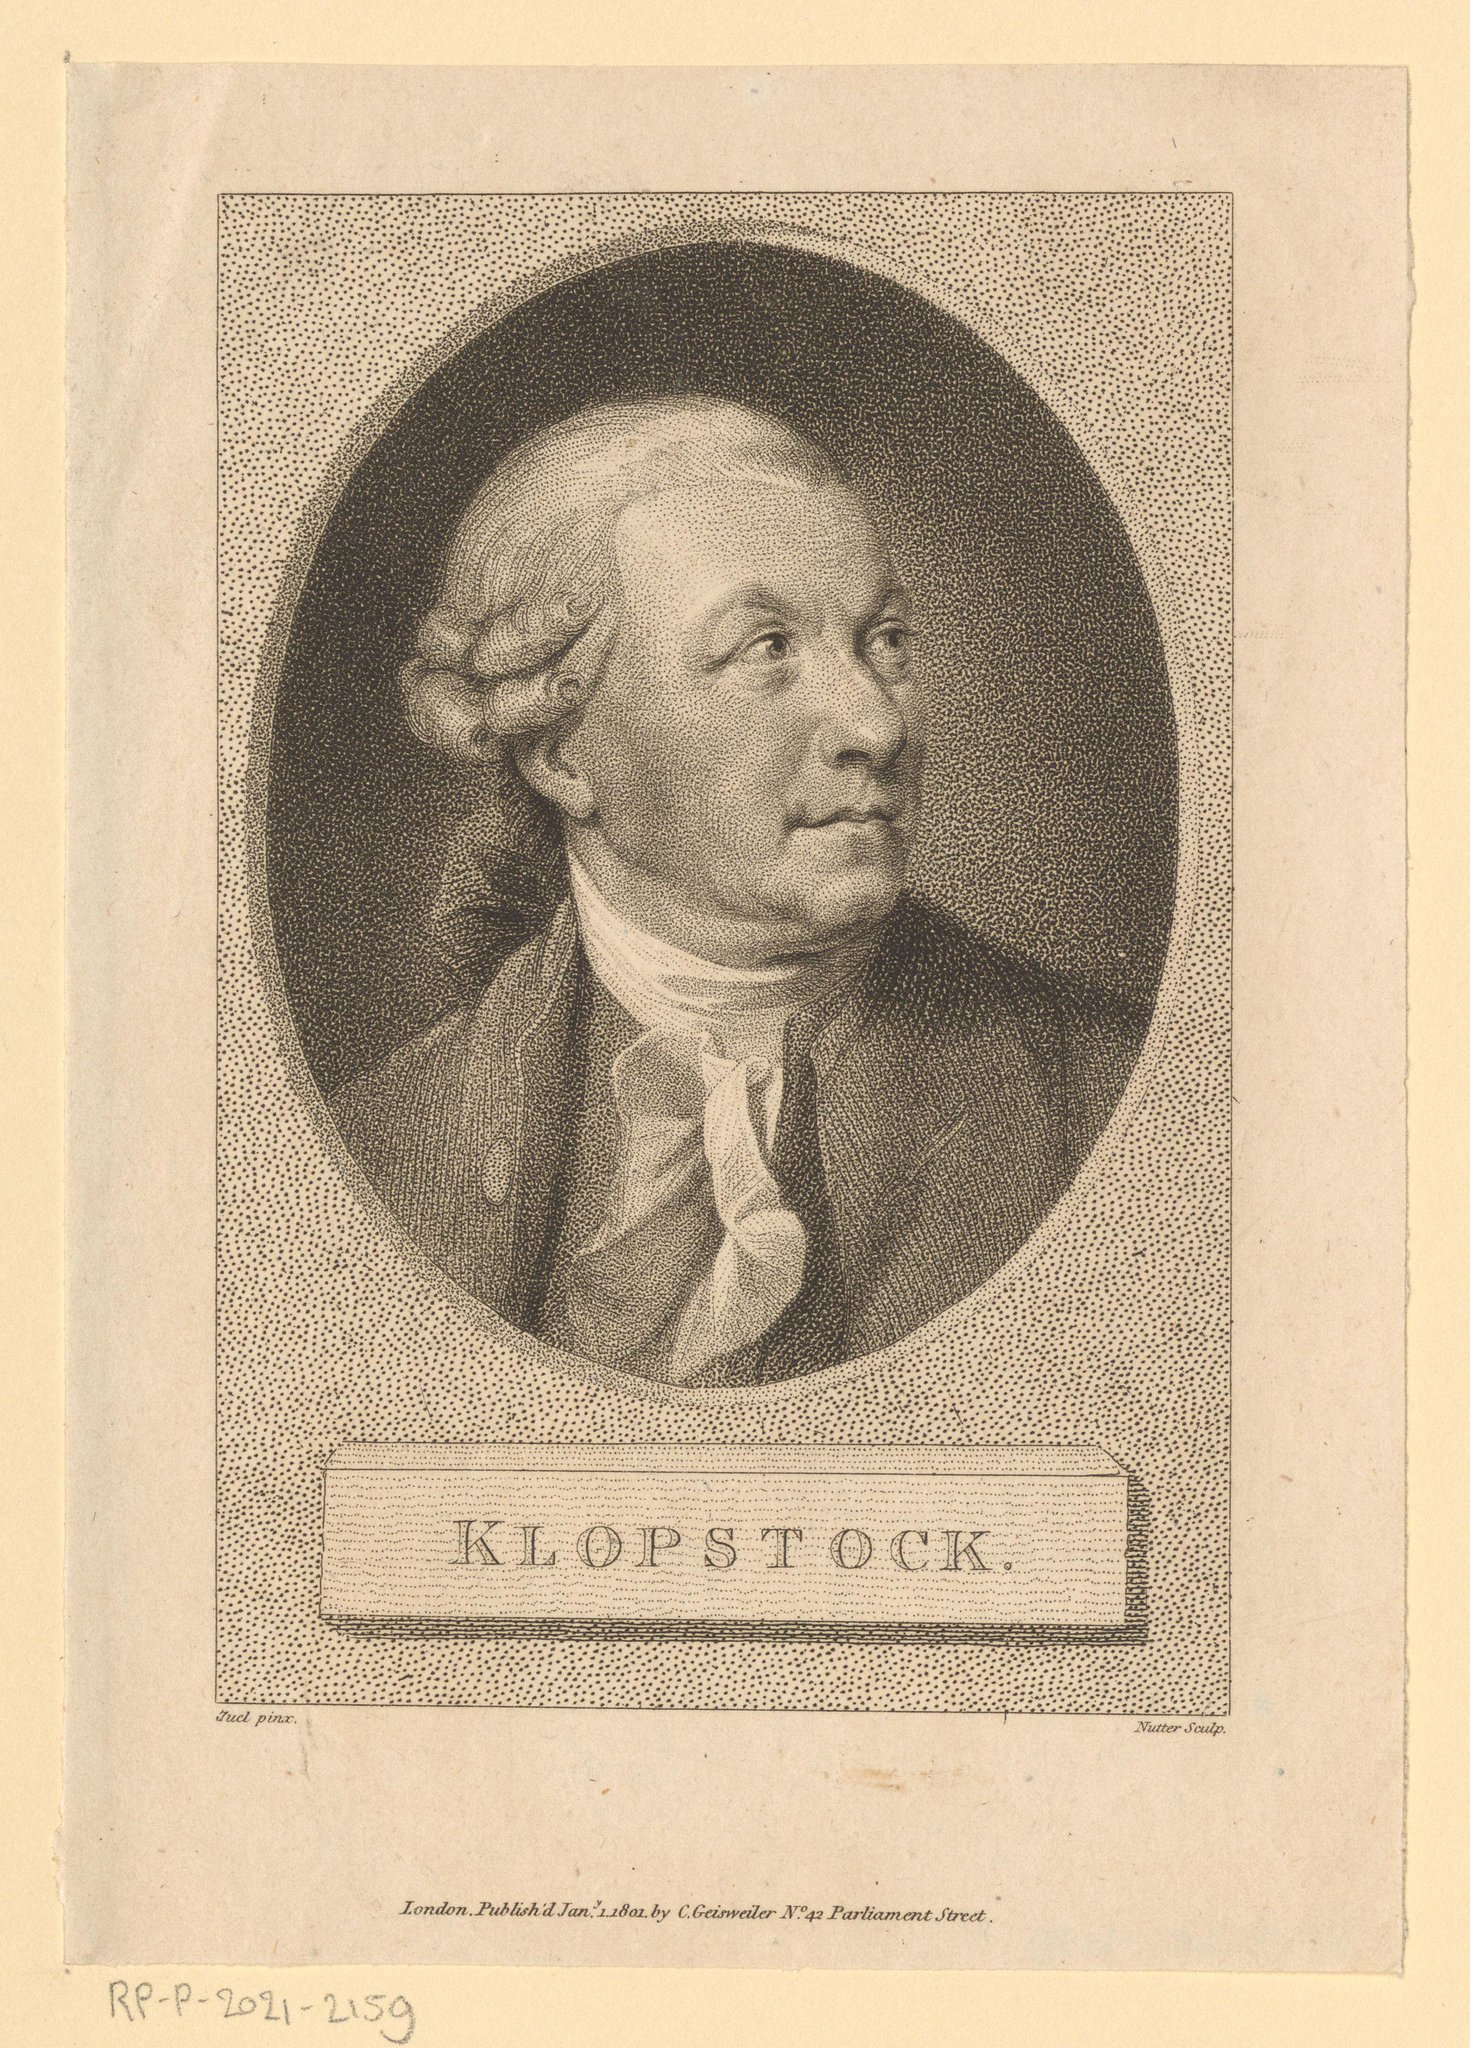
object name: print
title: Portret van Friedrich Gottlieb Klopstock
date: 1801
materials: paper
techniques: etching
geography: london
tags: historical persons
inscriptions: date